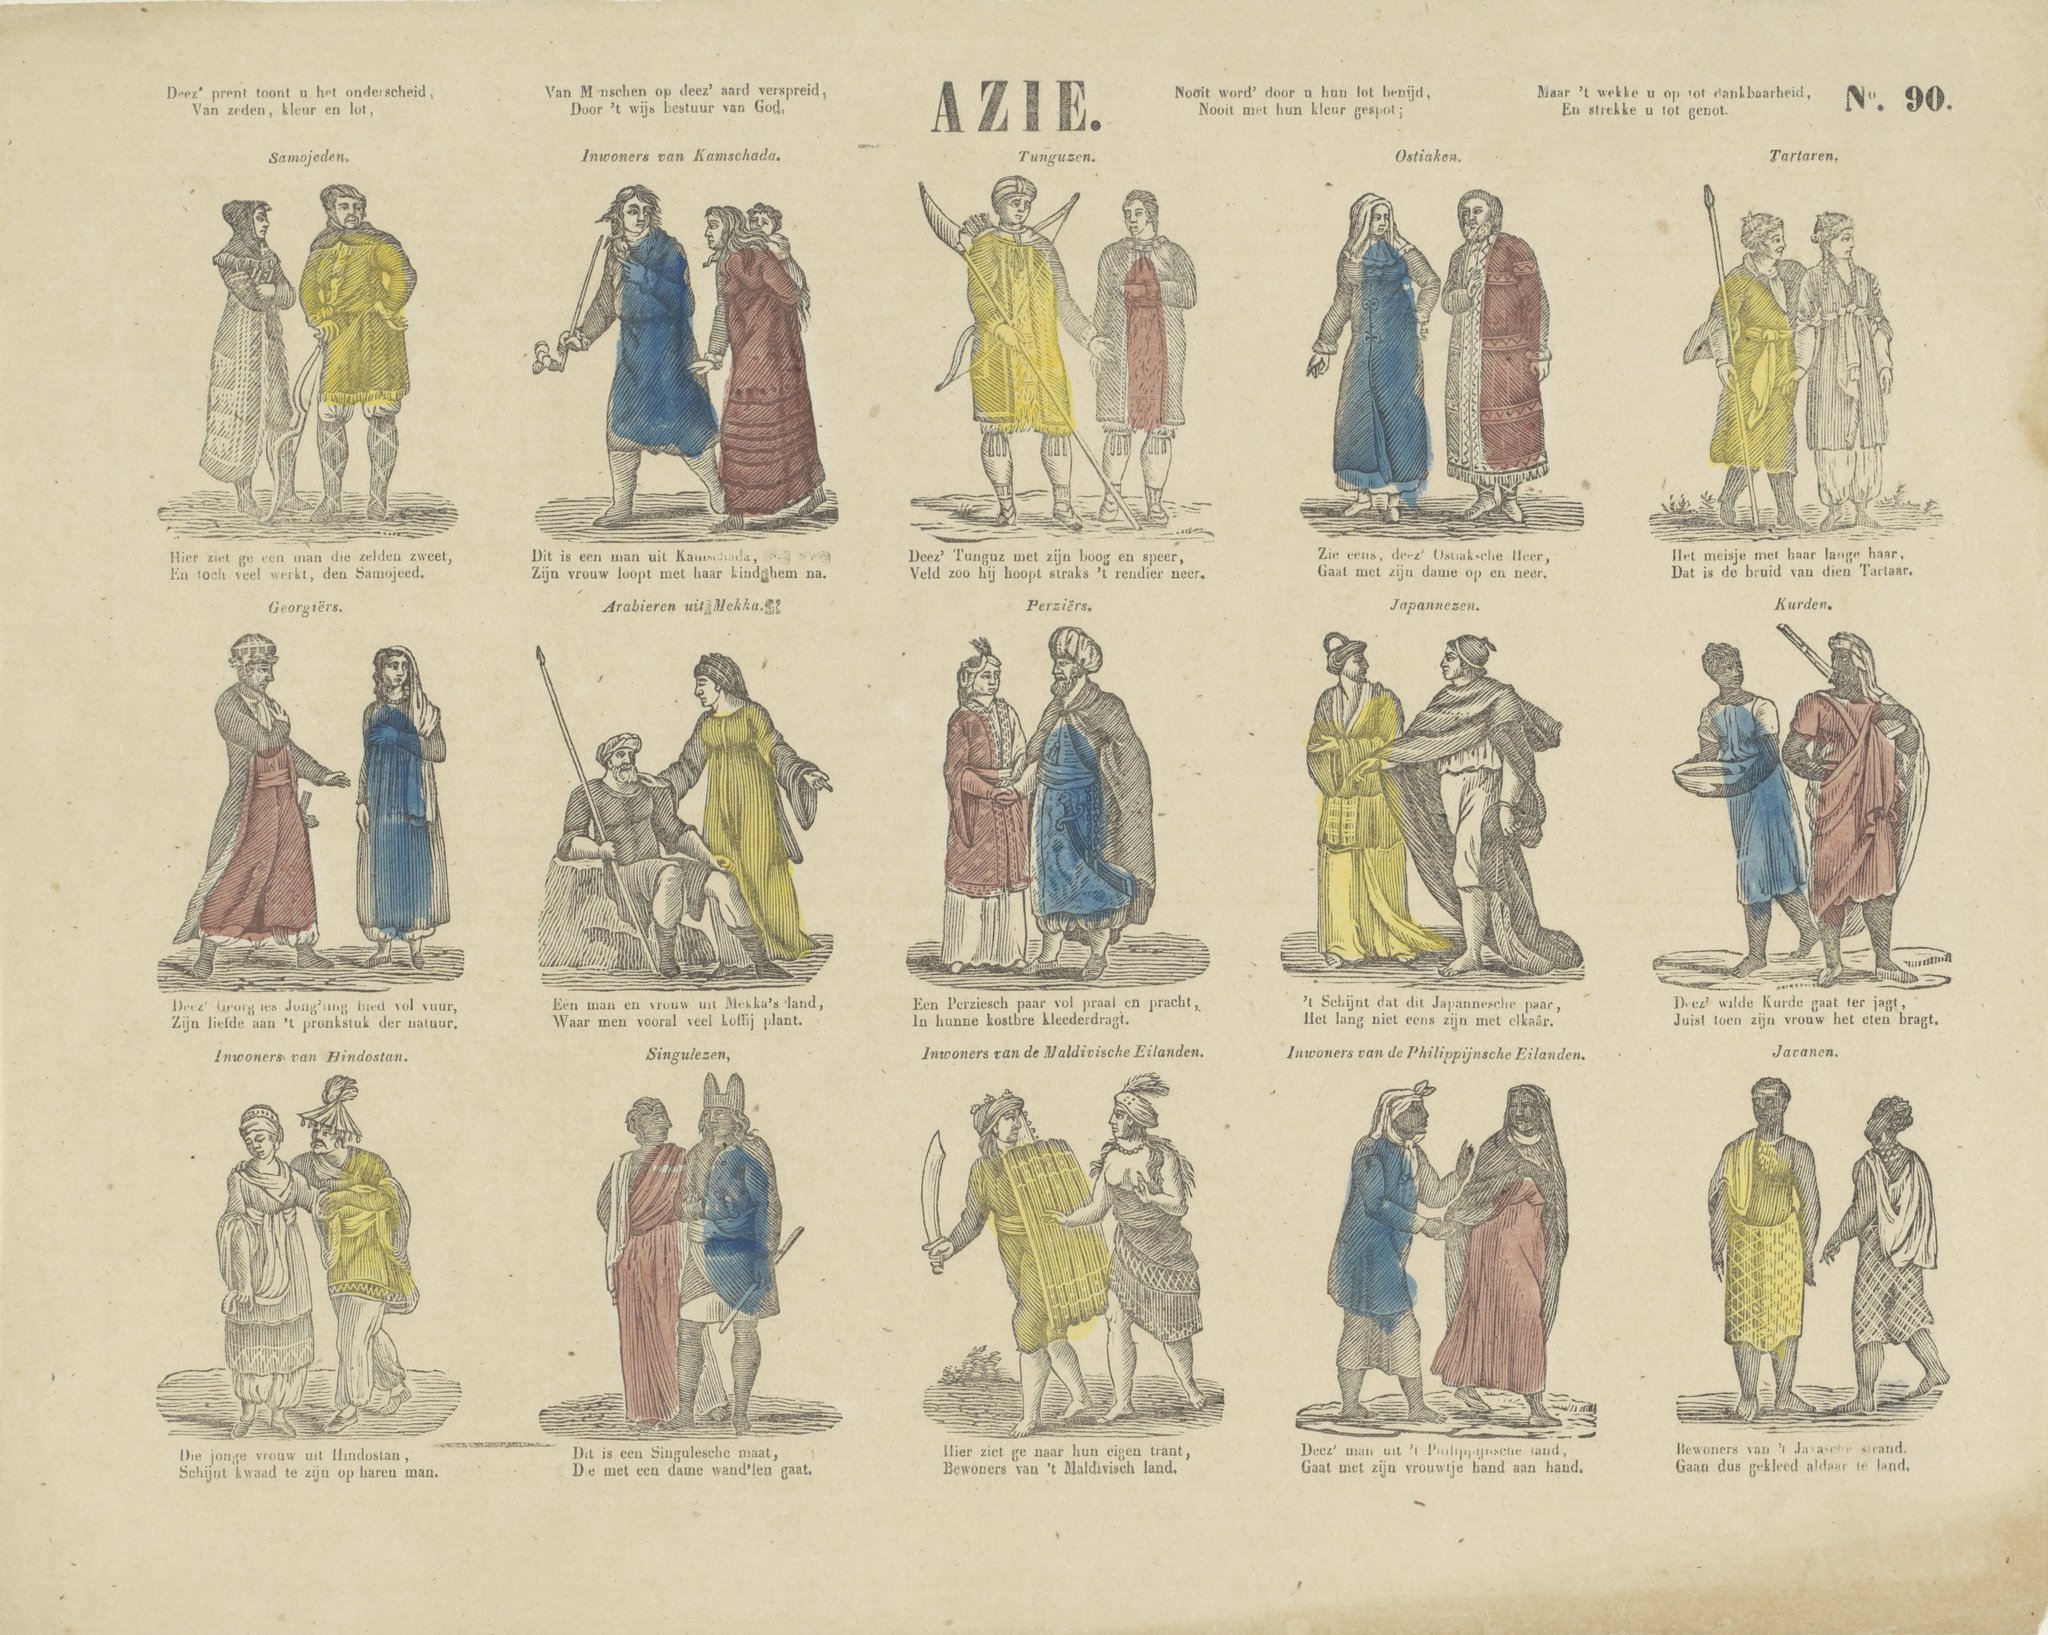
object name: popular print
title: Azie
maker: Anonymous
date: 1850-1870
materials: paper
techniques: colour, letterpress printing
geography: netherlands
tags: asiatic races and peoples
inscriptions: collector's mark: Lugt 2760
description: Blad met 15 voorstellingen van verschillende Aziatische paren. Onder elke afbeelding een tweeregelig vers. Genummerd rechtsboven: No. 90.